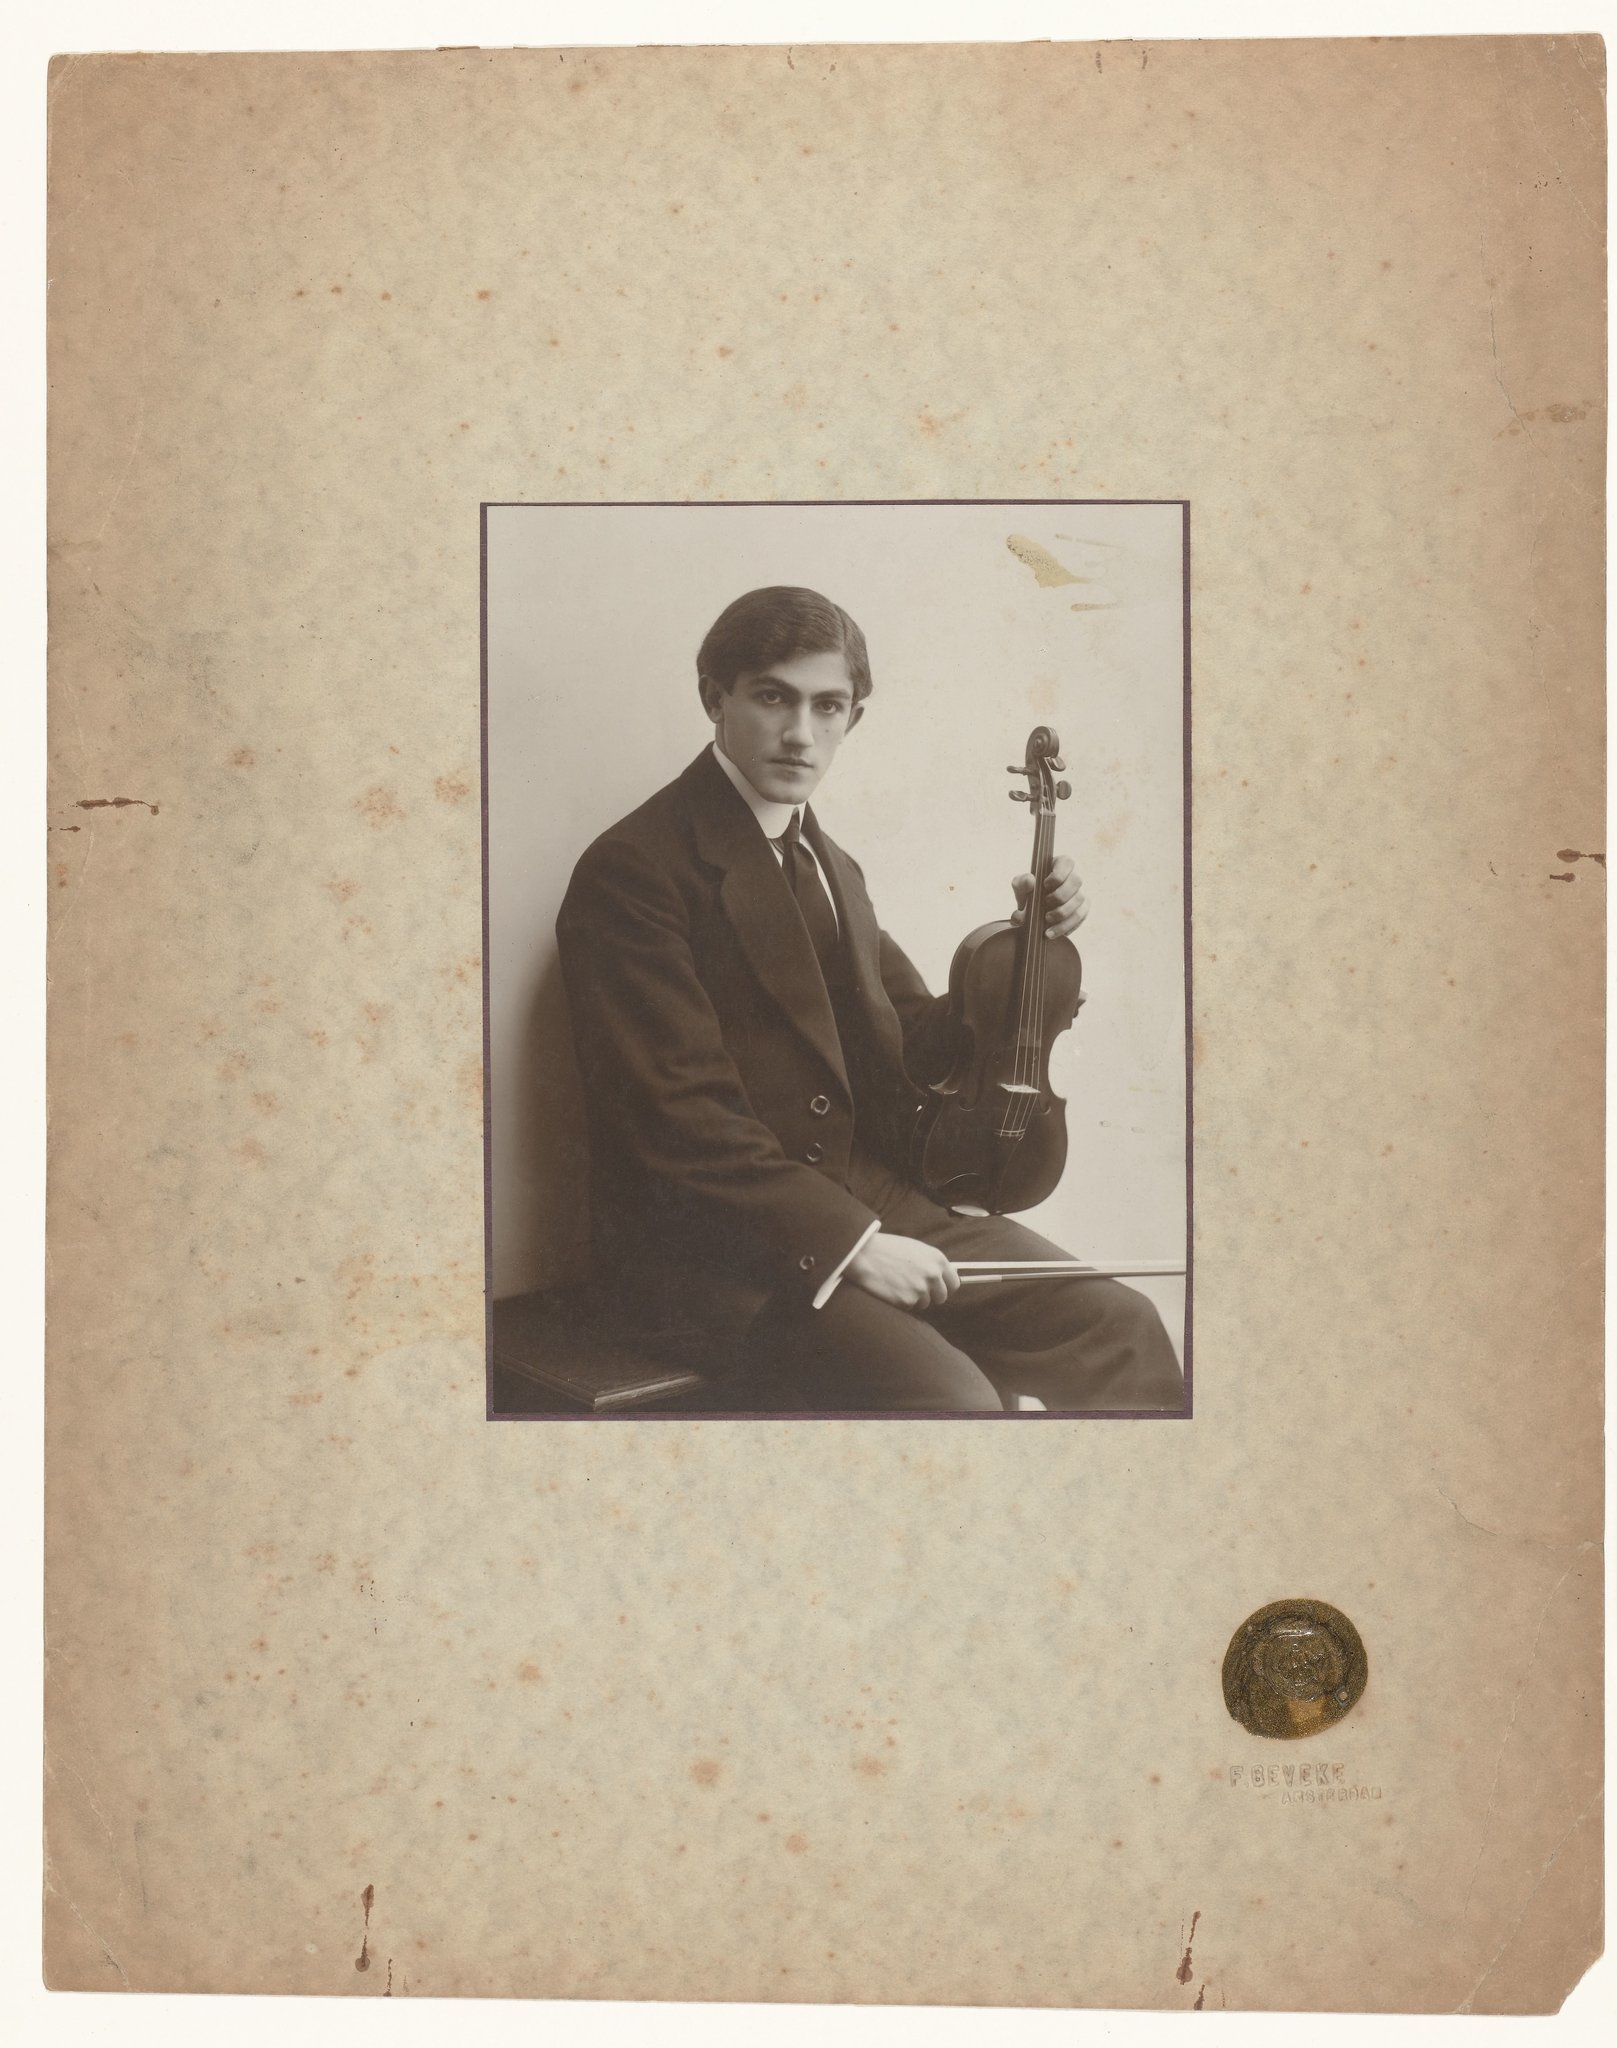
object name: photograph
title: Portret van een violist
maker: frits geveke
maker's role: fotograaf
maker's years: 1878-1950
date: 1910-1940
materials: paper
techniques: gelatin silver print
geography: amsterdam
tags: violin, fiddle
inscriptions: name: ‘F. Geveke Amsterdam’